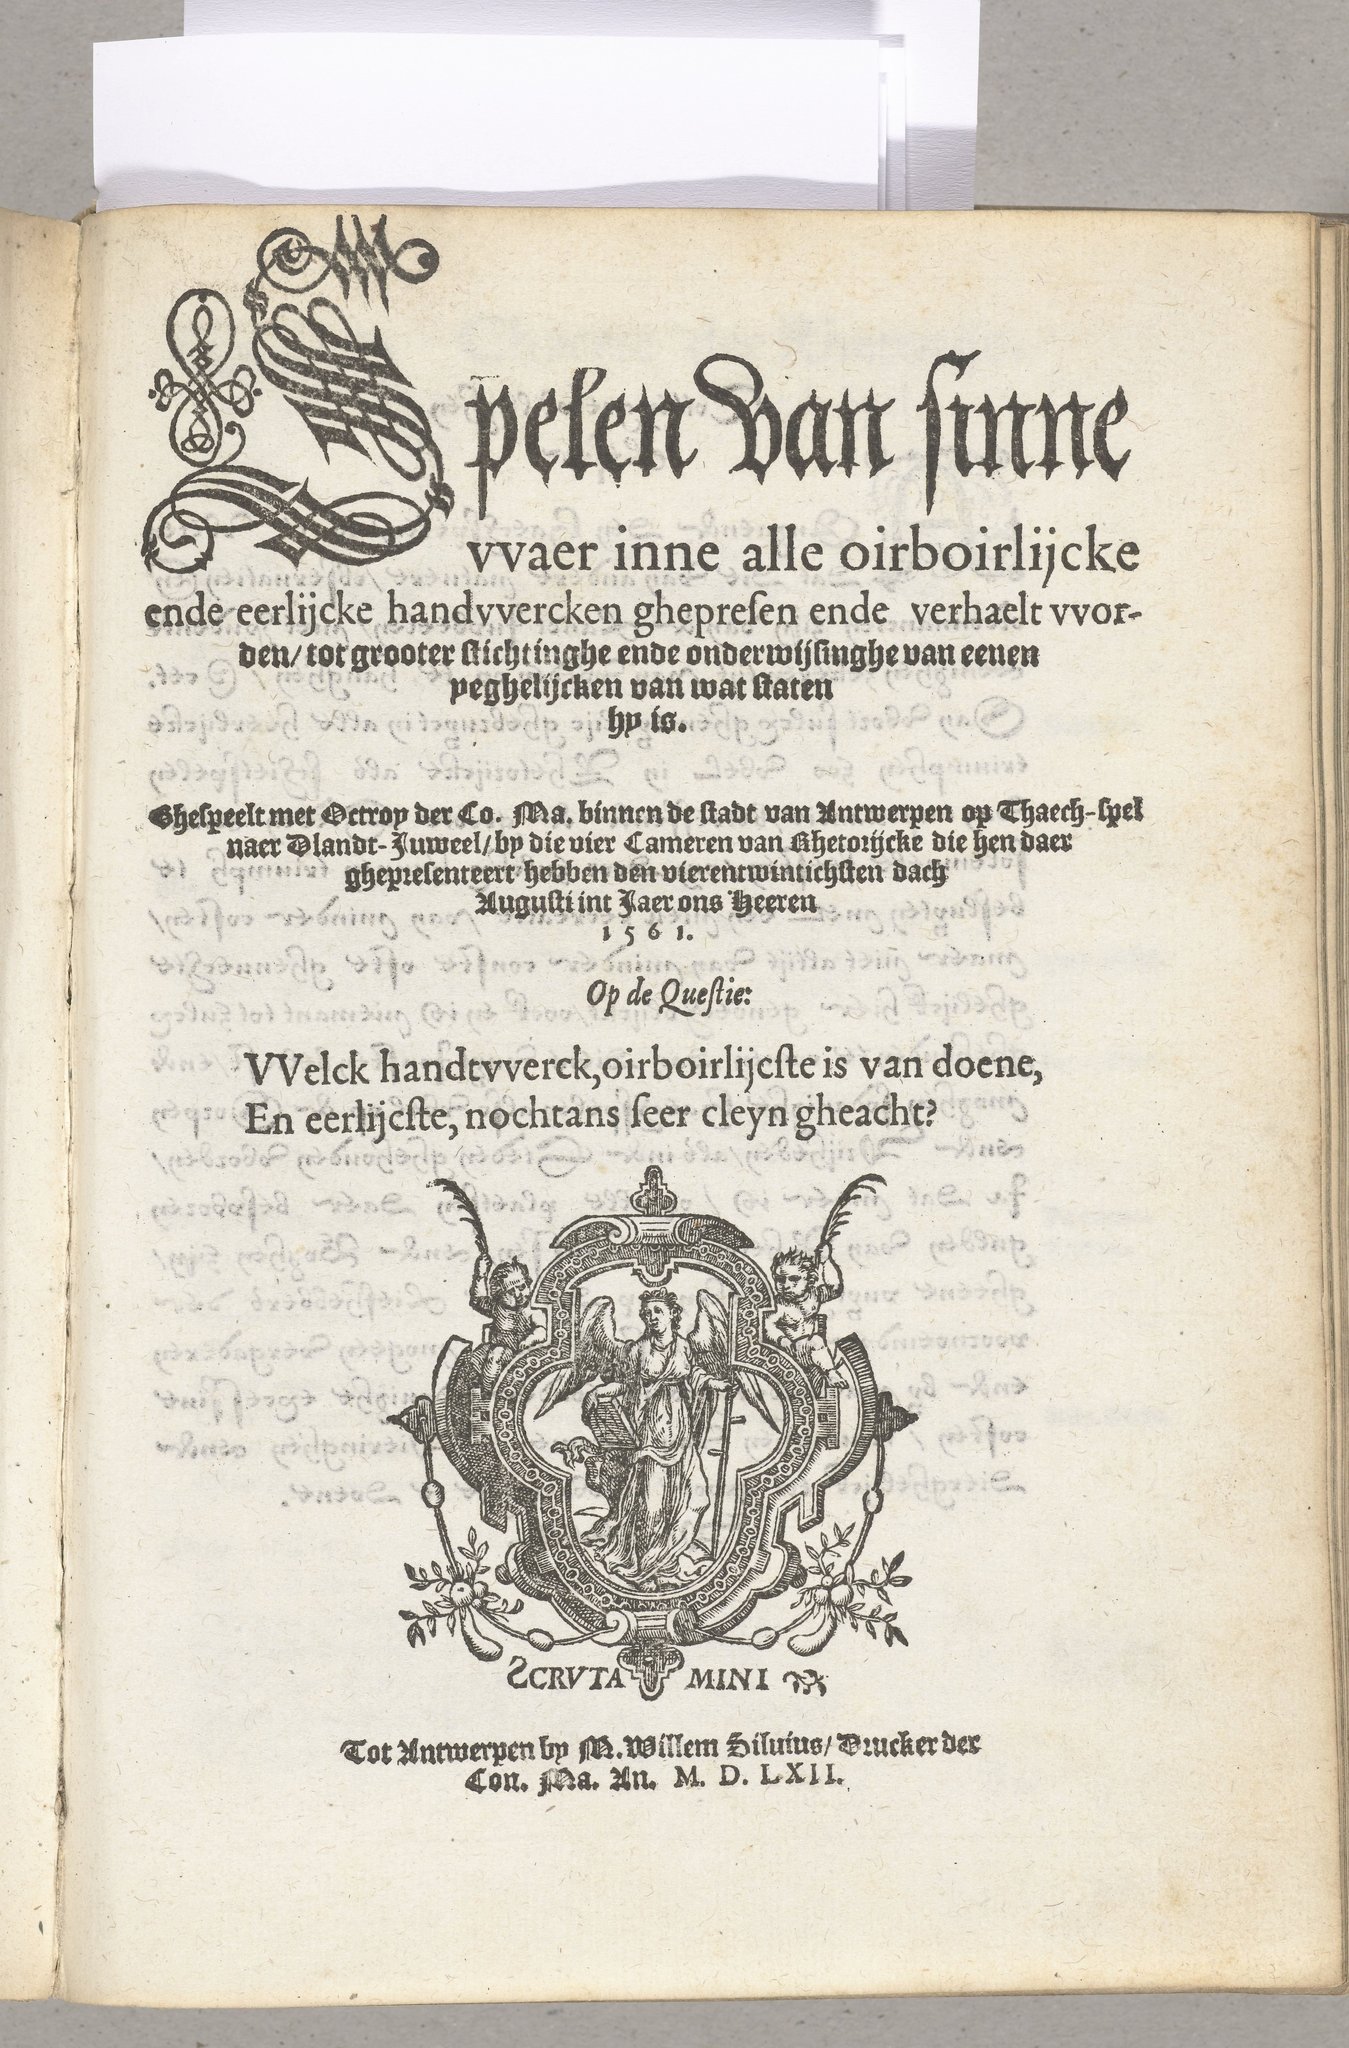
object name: print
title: Titelpagina voor: Spelen van sinne waer inne alle oirboirlijcke ende eerlijcke handwercken ghepresen ende verhaelt worden tot grooter stichtinghe ende onderwijsinghe van eene yeghelijcken van wat staten hy is. Ghespeelt met octroy der Co. Ma. binnen de Stadt van Antwerpen op Thaech-spel naer Dlandt-Juweel, by die vier cameren van Rhetorijcke die hen daer ghepresenteert hebben den vierentwintichsten dach Augusti int Jaer ons Heeren 1561.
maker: Anonymous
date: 1562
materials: paper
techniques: letterpress printing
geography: antwerp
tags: antwerp, leiden, printer, publisher, willem silvius, device (trade-mark of printer or publisher)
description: Illustratie in het volgende werk in dezelfde band: Spelen van sinne waer inne alle oirboirlijcke ende eerlijcke handwercken ghepresen ende verhaelt worden tot grooter stichtinghe ende onderwijsinghe van eene yeghelijcken van wat staten hy is. Ghespeelt met octroy der Co. Ma. binnen de Stadt van Antwerpen op Thaech-spel naer Dlandt-Juweel, by die vier cameren van Rhetorijcke die hen daer ghepresenteert hebben den vierentwintichsten dach Augusti int Jaer ons Heeren 1561. Op de questie: Welck handtwerck, oirboirlijcste is van doene, en eerlijcste nochtans seer cleyn gheacht? Tot Antwerpen, by M. Willem Silvius, 1562, titelpagina. In het exemplaar in de Rijksmuseum Research Library, signatuur: 325 D 20.